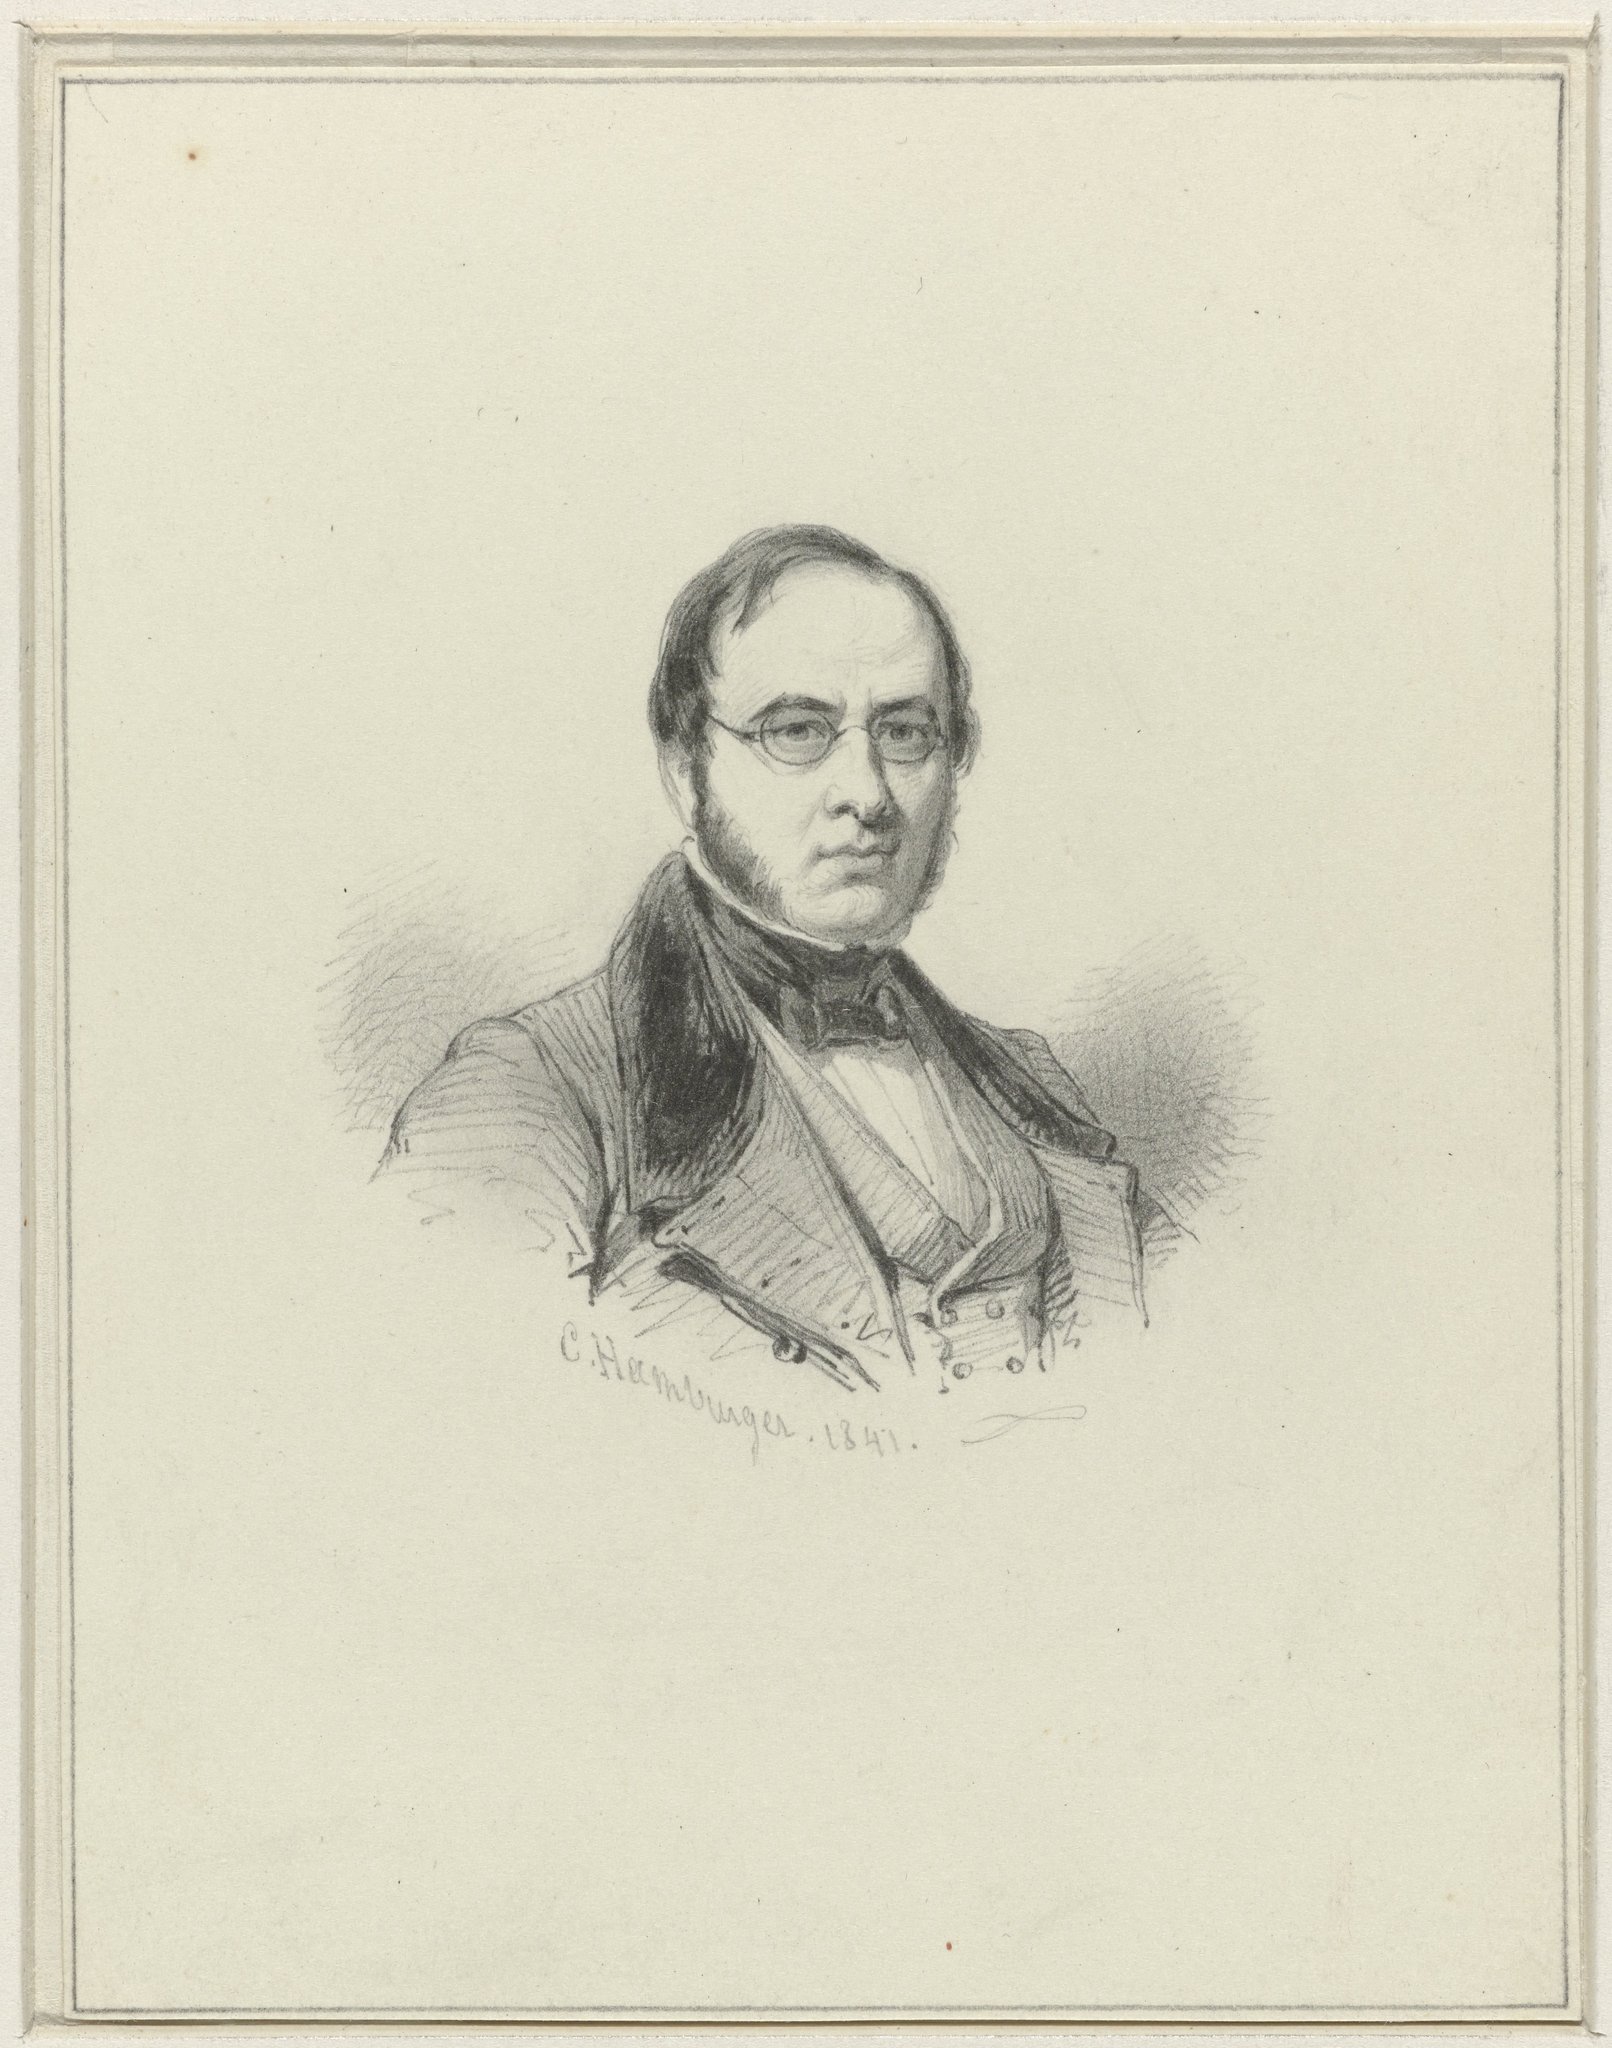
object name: drawing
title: Portret van André Benoit Barreau Taurel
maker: coenraad hamburger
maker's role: draughtsman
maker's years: 1809-1891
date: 1841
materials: paper, pencil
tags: paris, amsterdam, print maker, benoit taurel, historical persons, portrait, self-portrait of artist, portrait, self-portrait of graphic artist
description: Portret van de graveur en etser André Benoit Barreau Taurel.